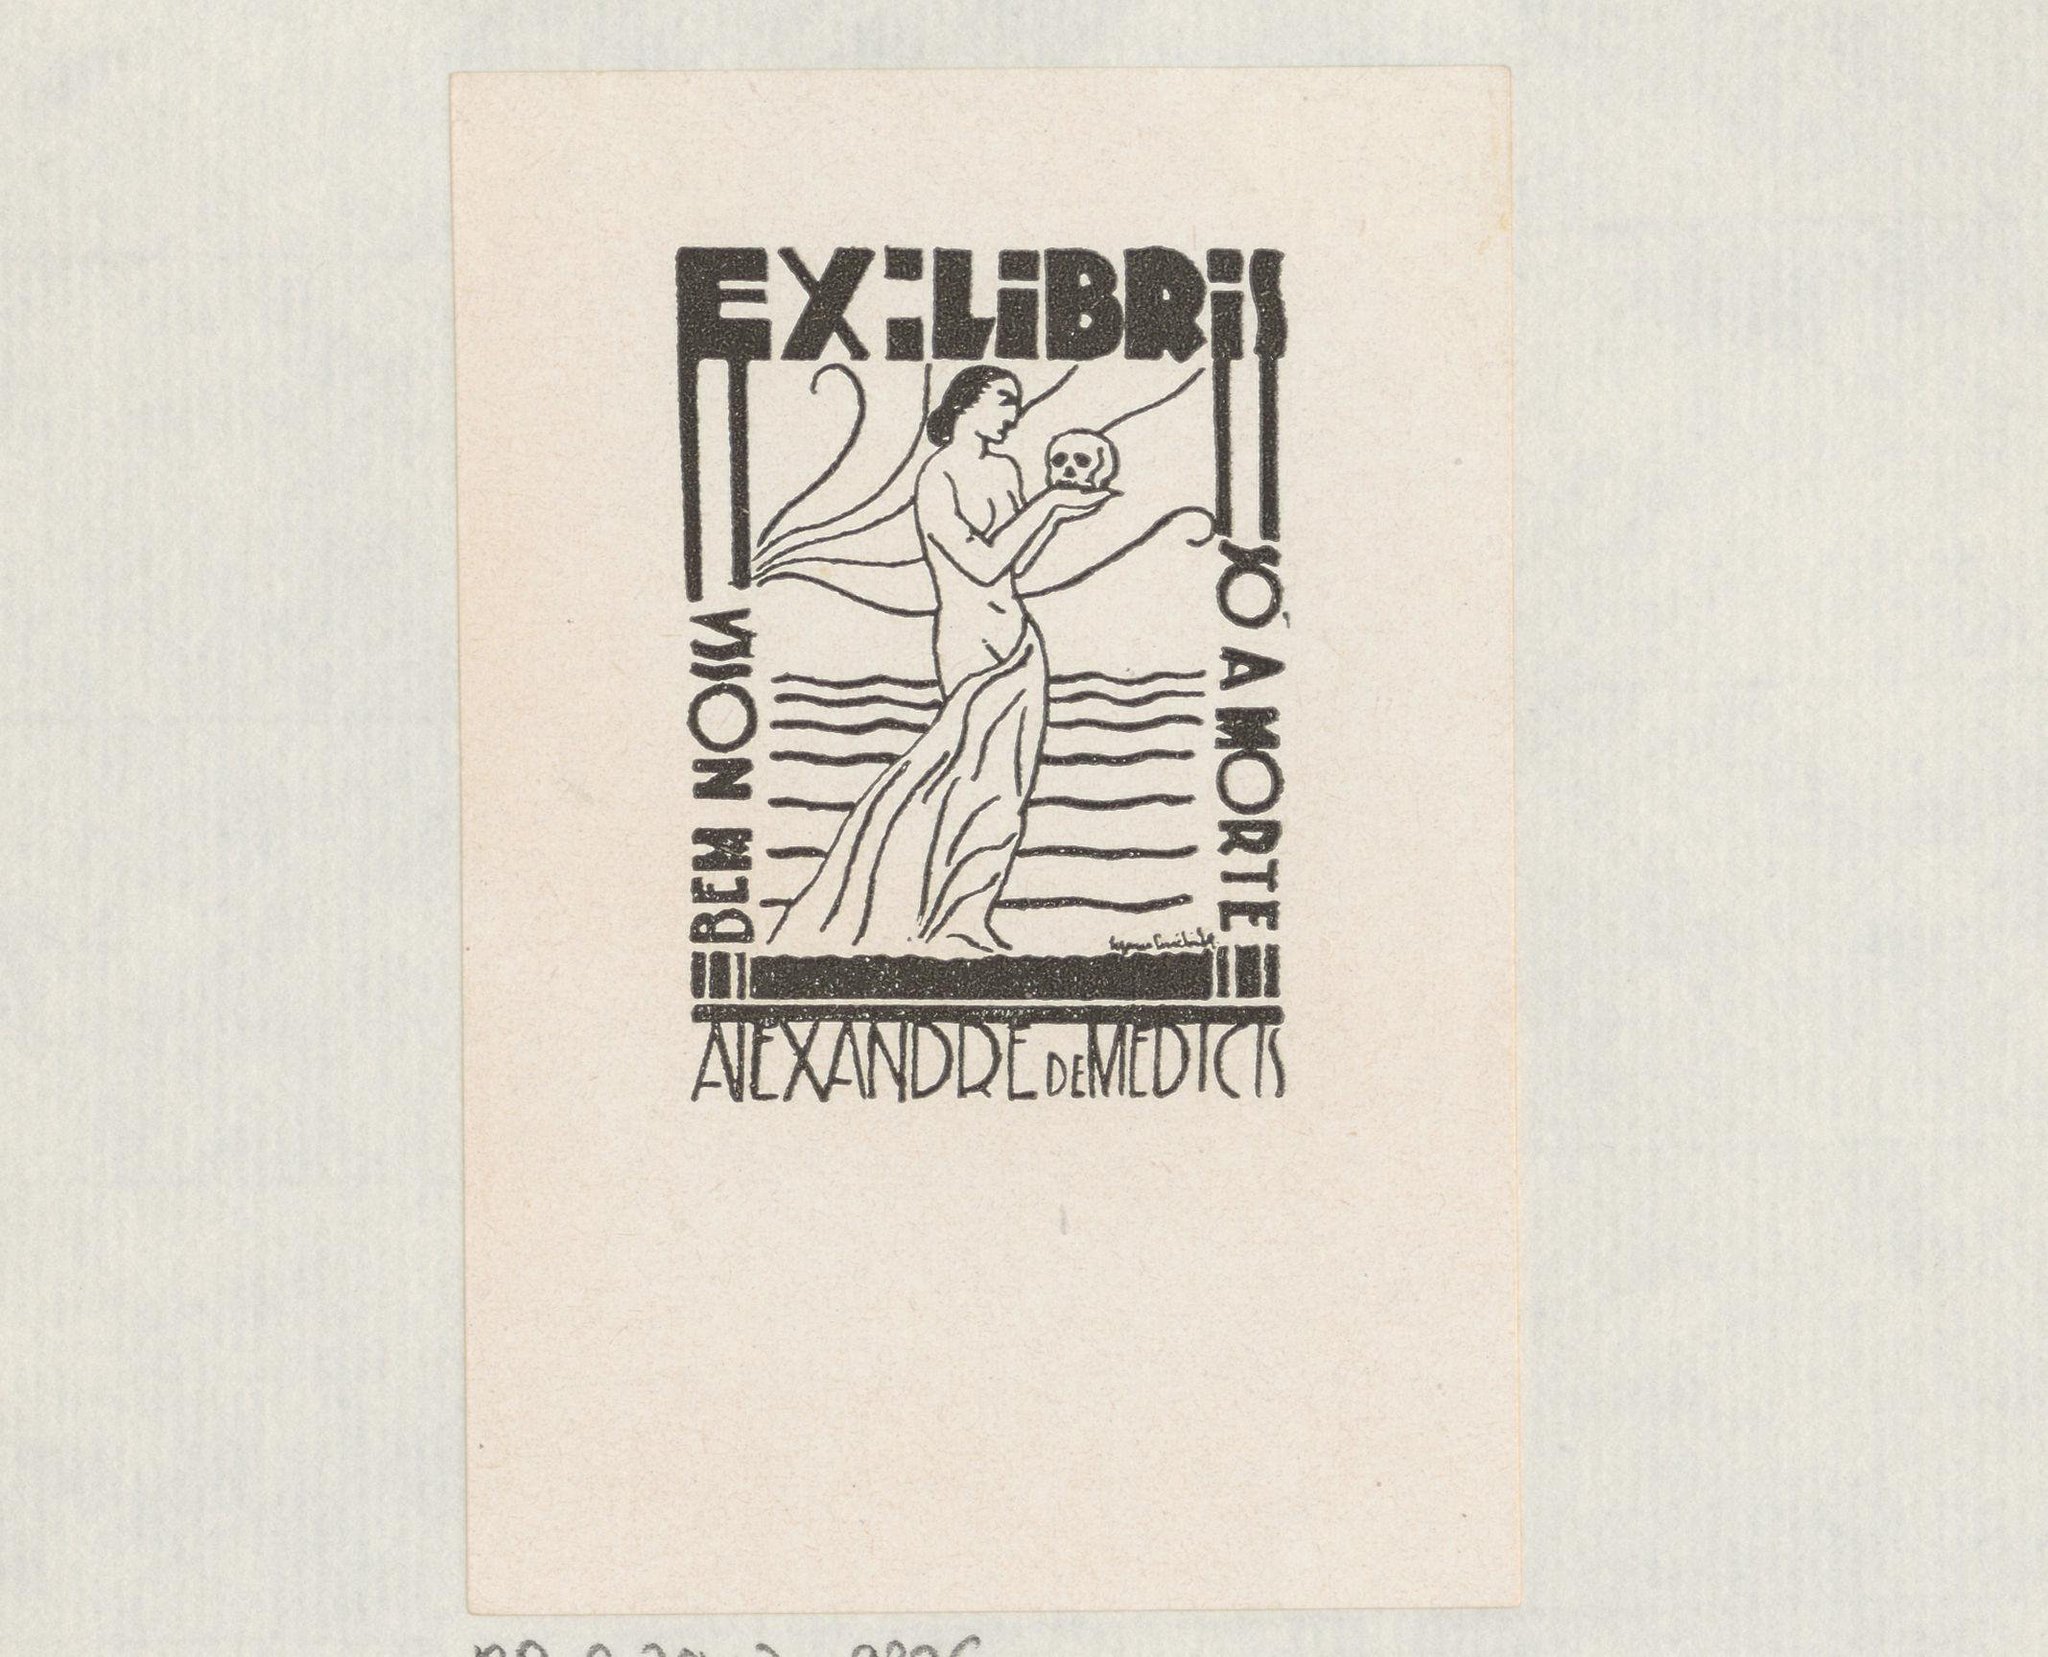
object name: bookplate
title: Ex libris van Alexandre de Médicis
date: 1900-1999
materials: paper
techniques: printing block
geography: portugal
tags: woman (showing herself) undressed, quasi-nude, death's head, skull (symbol of death)